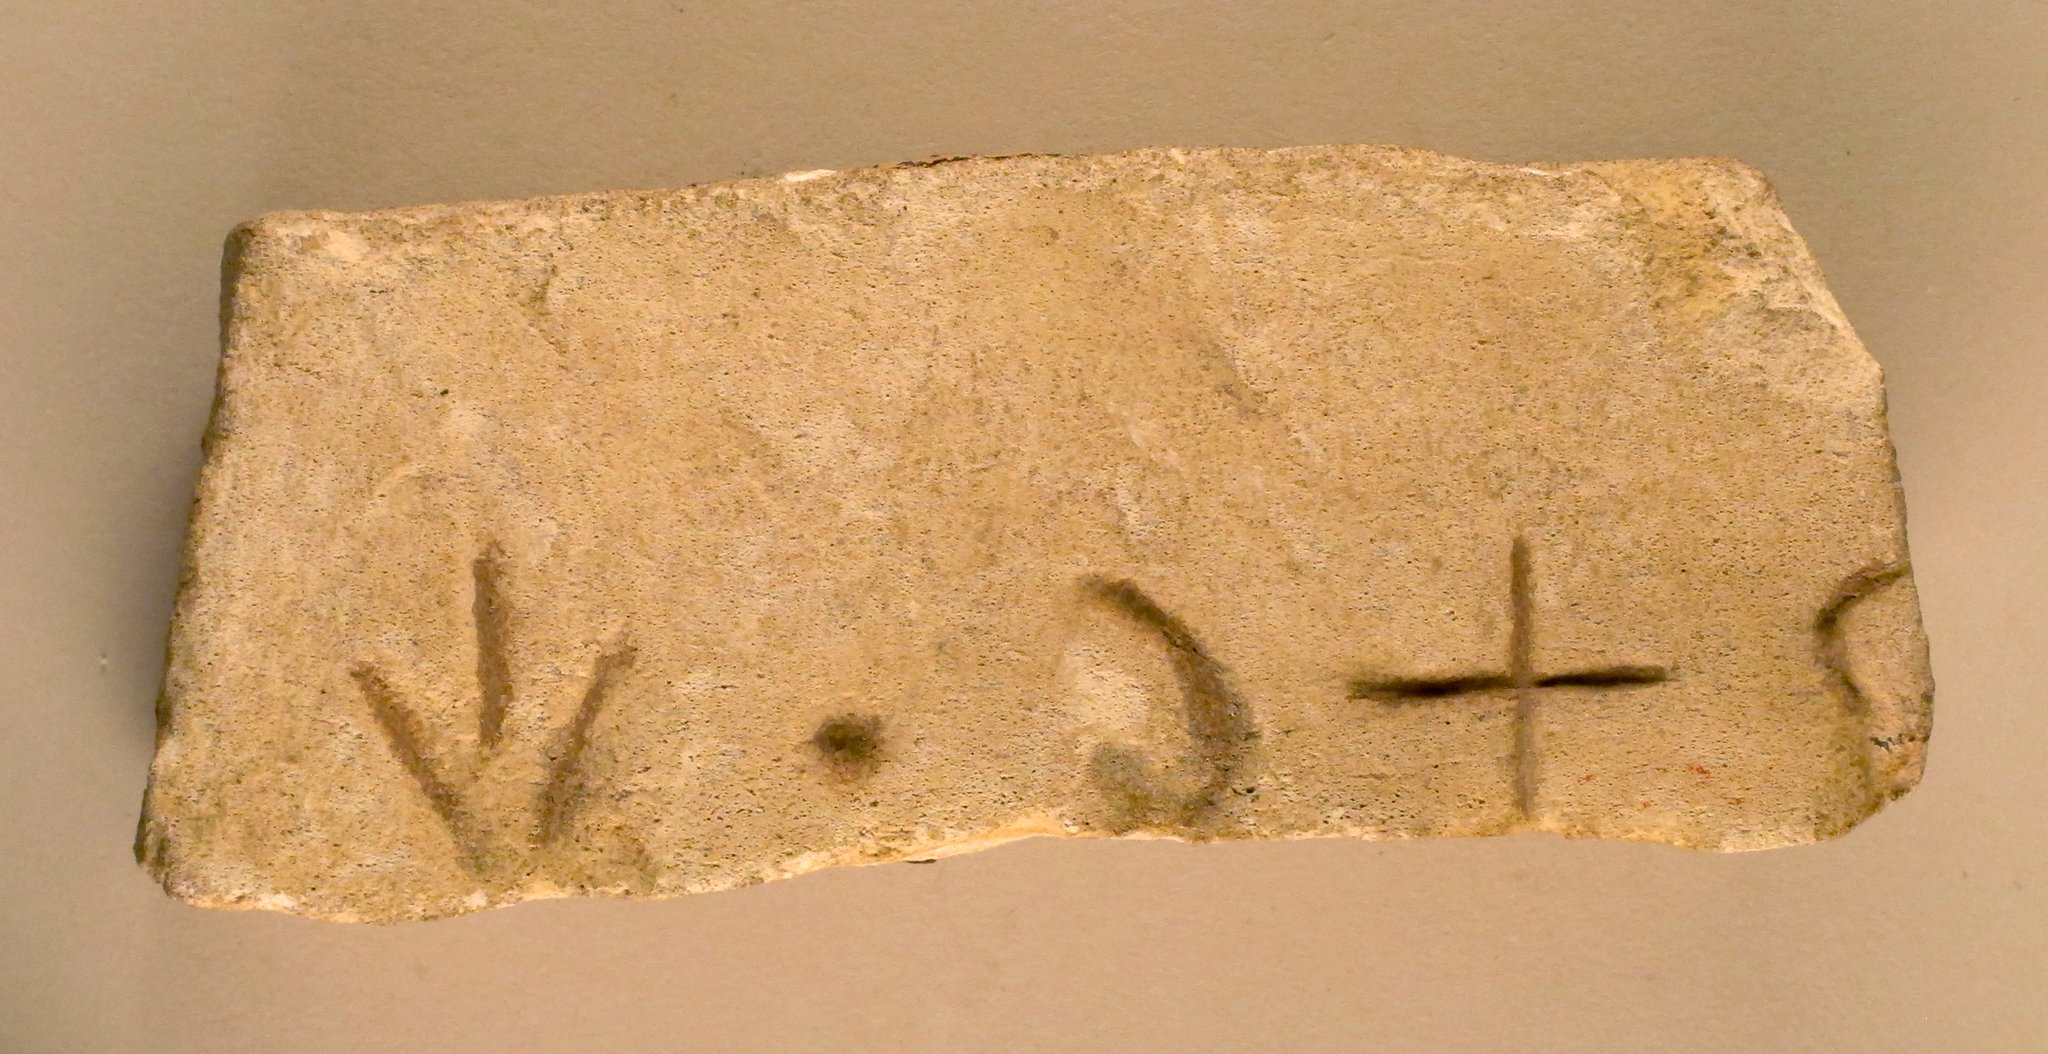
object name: statue base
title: Limestone inscribed fragment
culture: cypriot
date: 3900 BCE-100 CE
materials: limestone